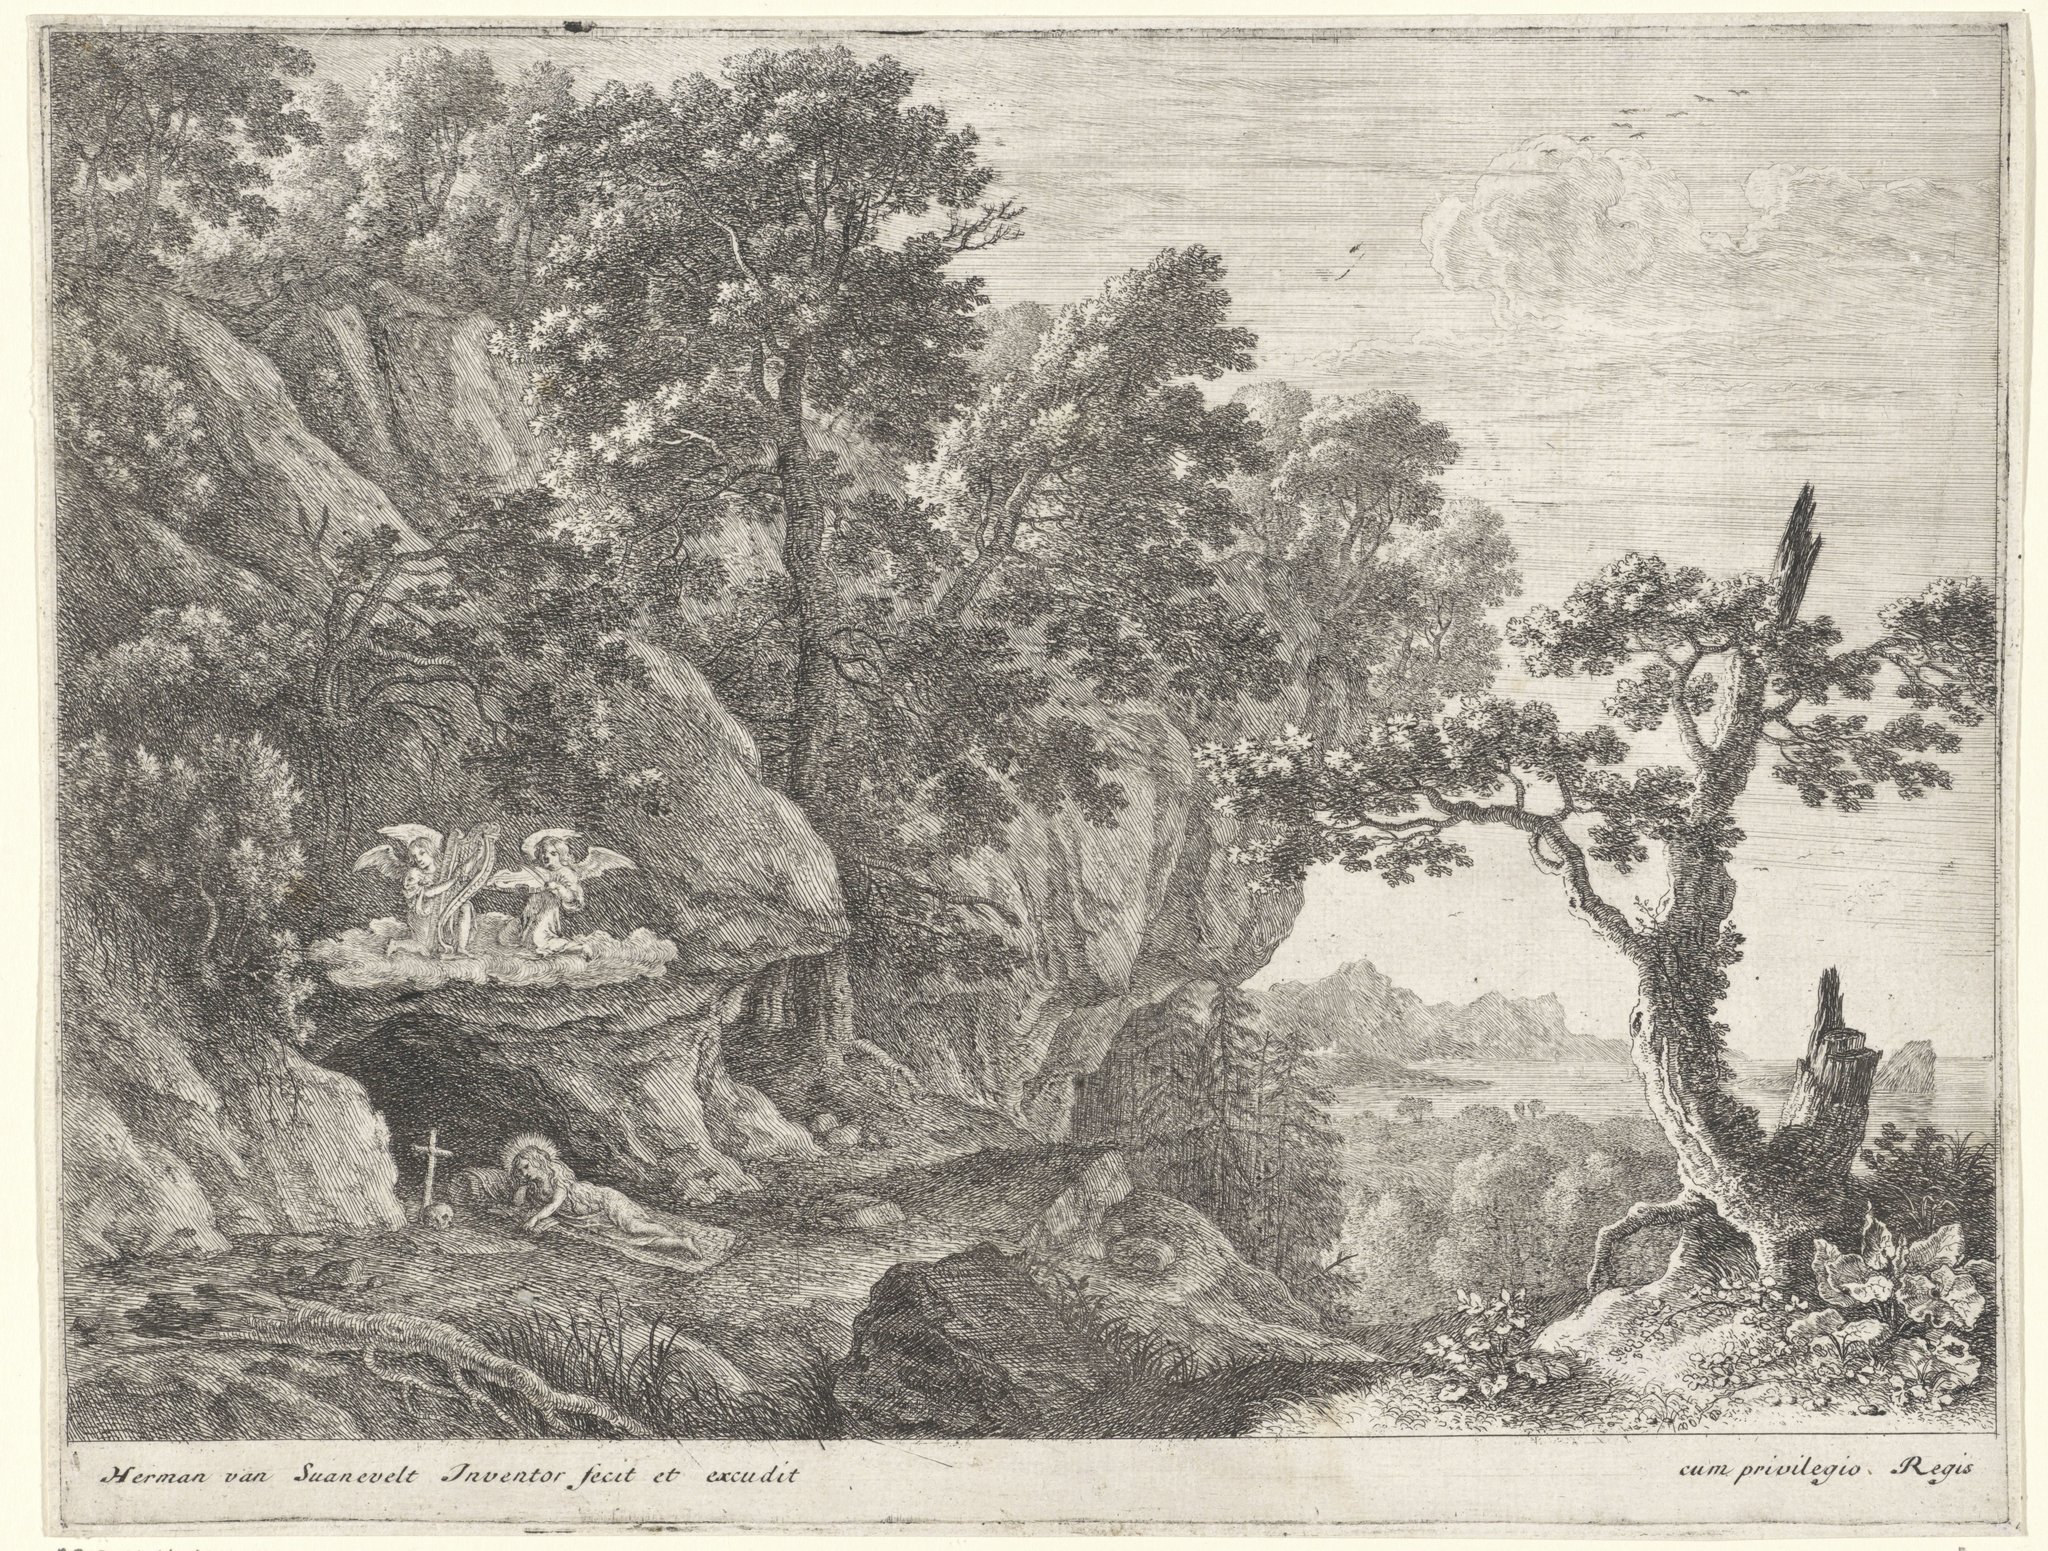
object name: print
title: Landschappen met boetvaardige heiligen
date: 1650-1655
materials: paper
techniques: etching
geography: paris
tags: the penitent st. mary magdalene (often before a cave, possibly at la sainte-baume hill): her long hair covers her (naked) body, she reads, meditates or raises her tear-filled eyes towards heaven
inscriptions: collector's mark: Lugt 10, collector's mark: Lugt 11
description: Maria Magdalena ligt voor een grot op een kleed. Naast haar zijn een schedel en een kruis te zien, haar attributen. Op een wolk boven haar knielen twee musicerende engelen. De linkerengel bespeelt een harp en de rechterengel een viool. Het omringende landschap is met veel boompartijen gestoffeerd.